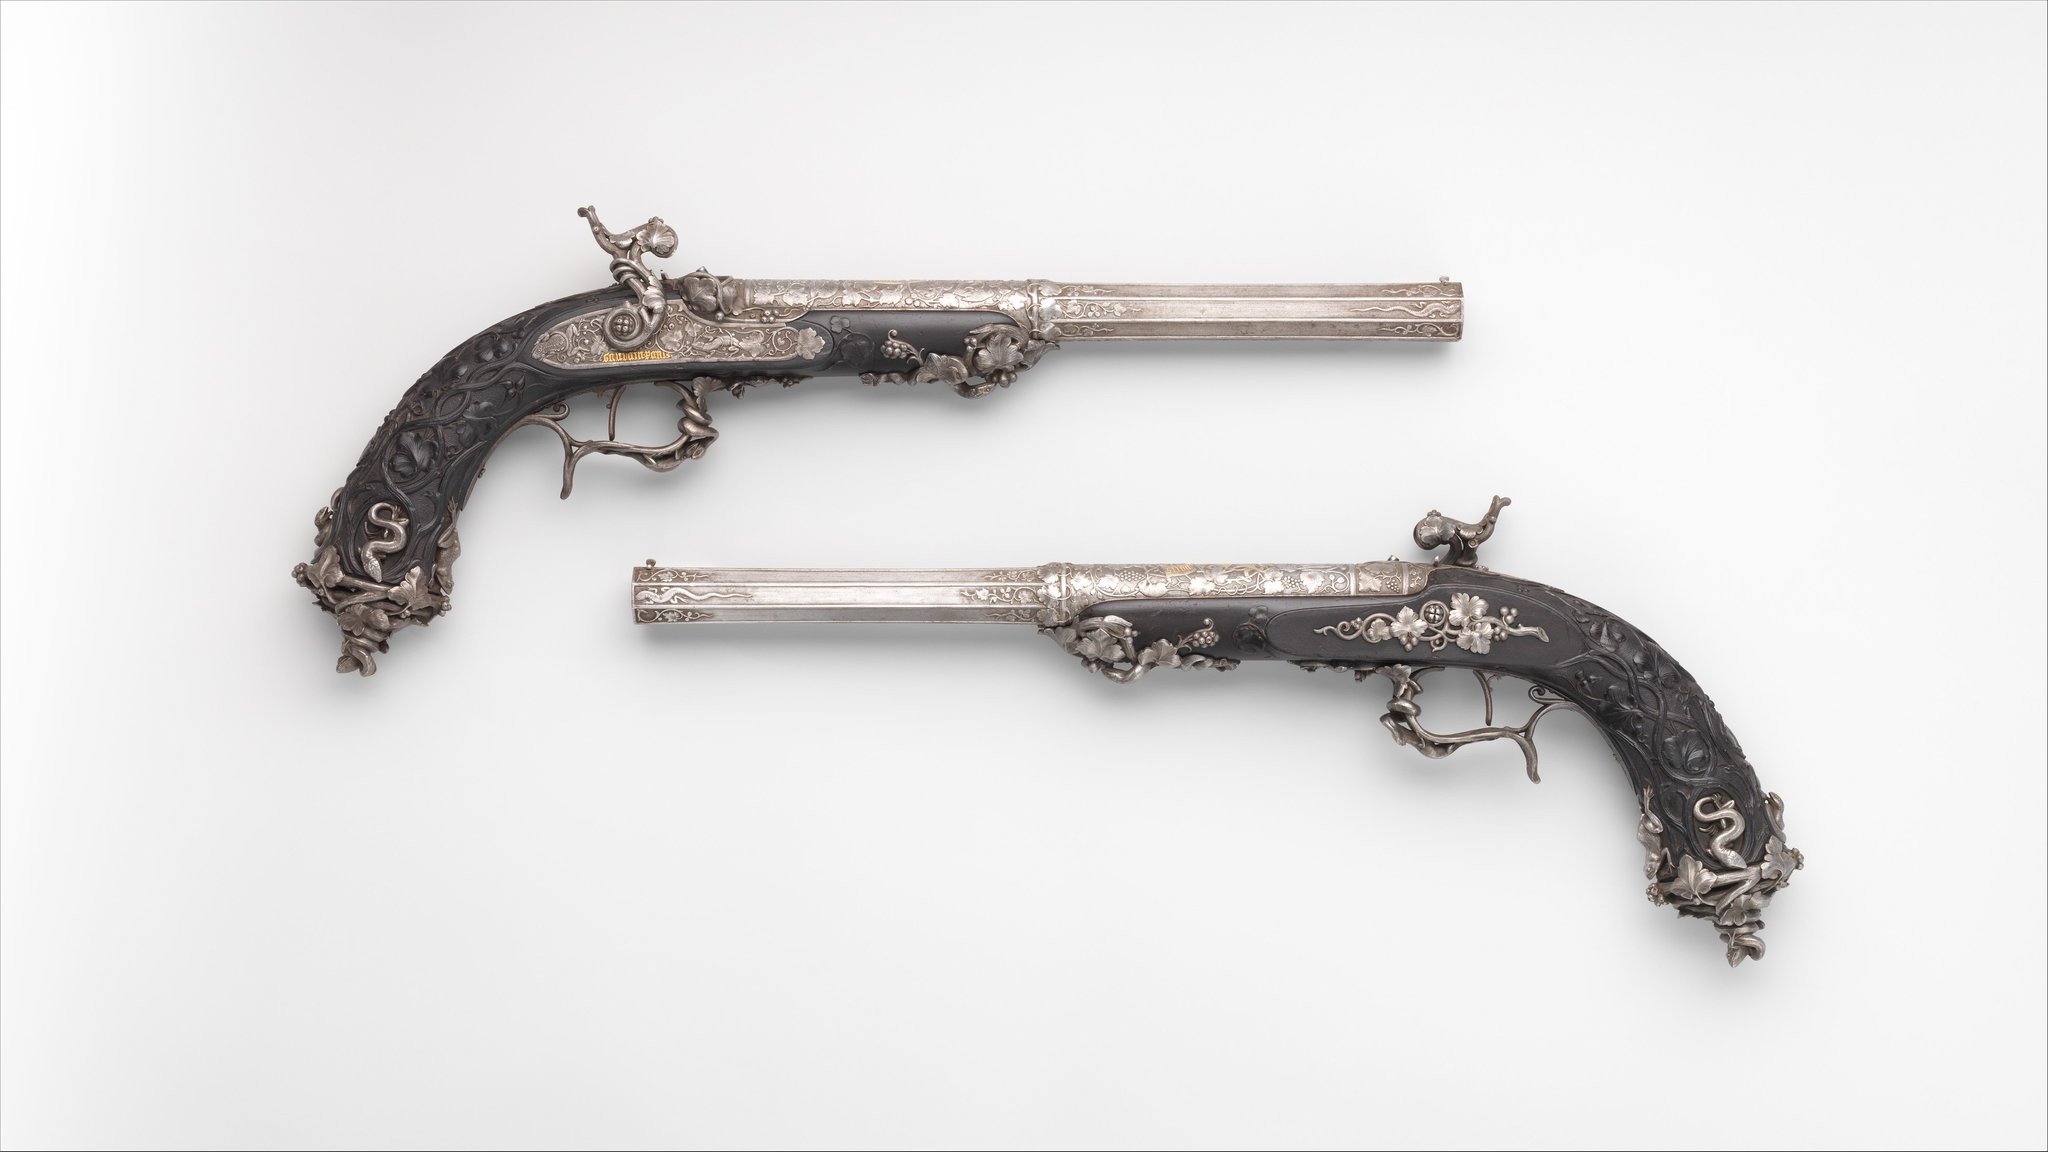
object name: percussion pistol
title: Pair of Percussion Target Pistols Made for Display at the Crystal Palace Exhibition in London, 1851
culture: french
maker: alfred gauvain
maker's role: gunsmith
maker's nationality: french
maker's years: 1801-1889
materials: gold, steel, wood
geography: france